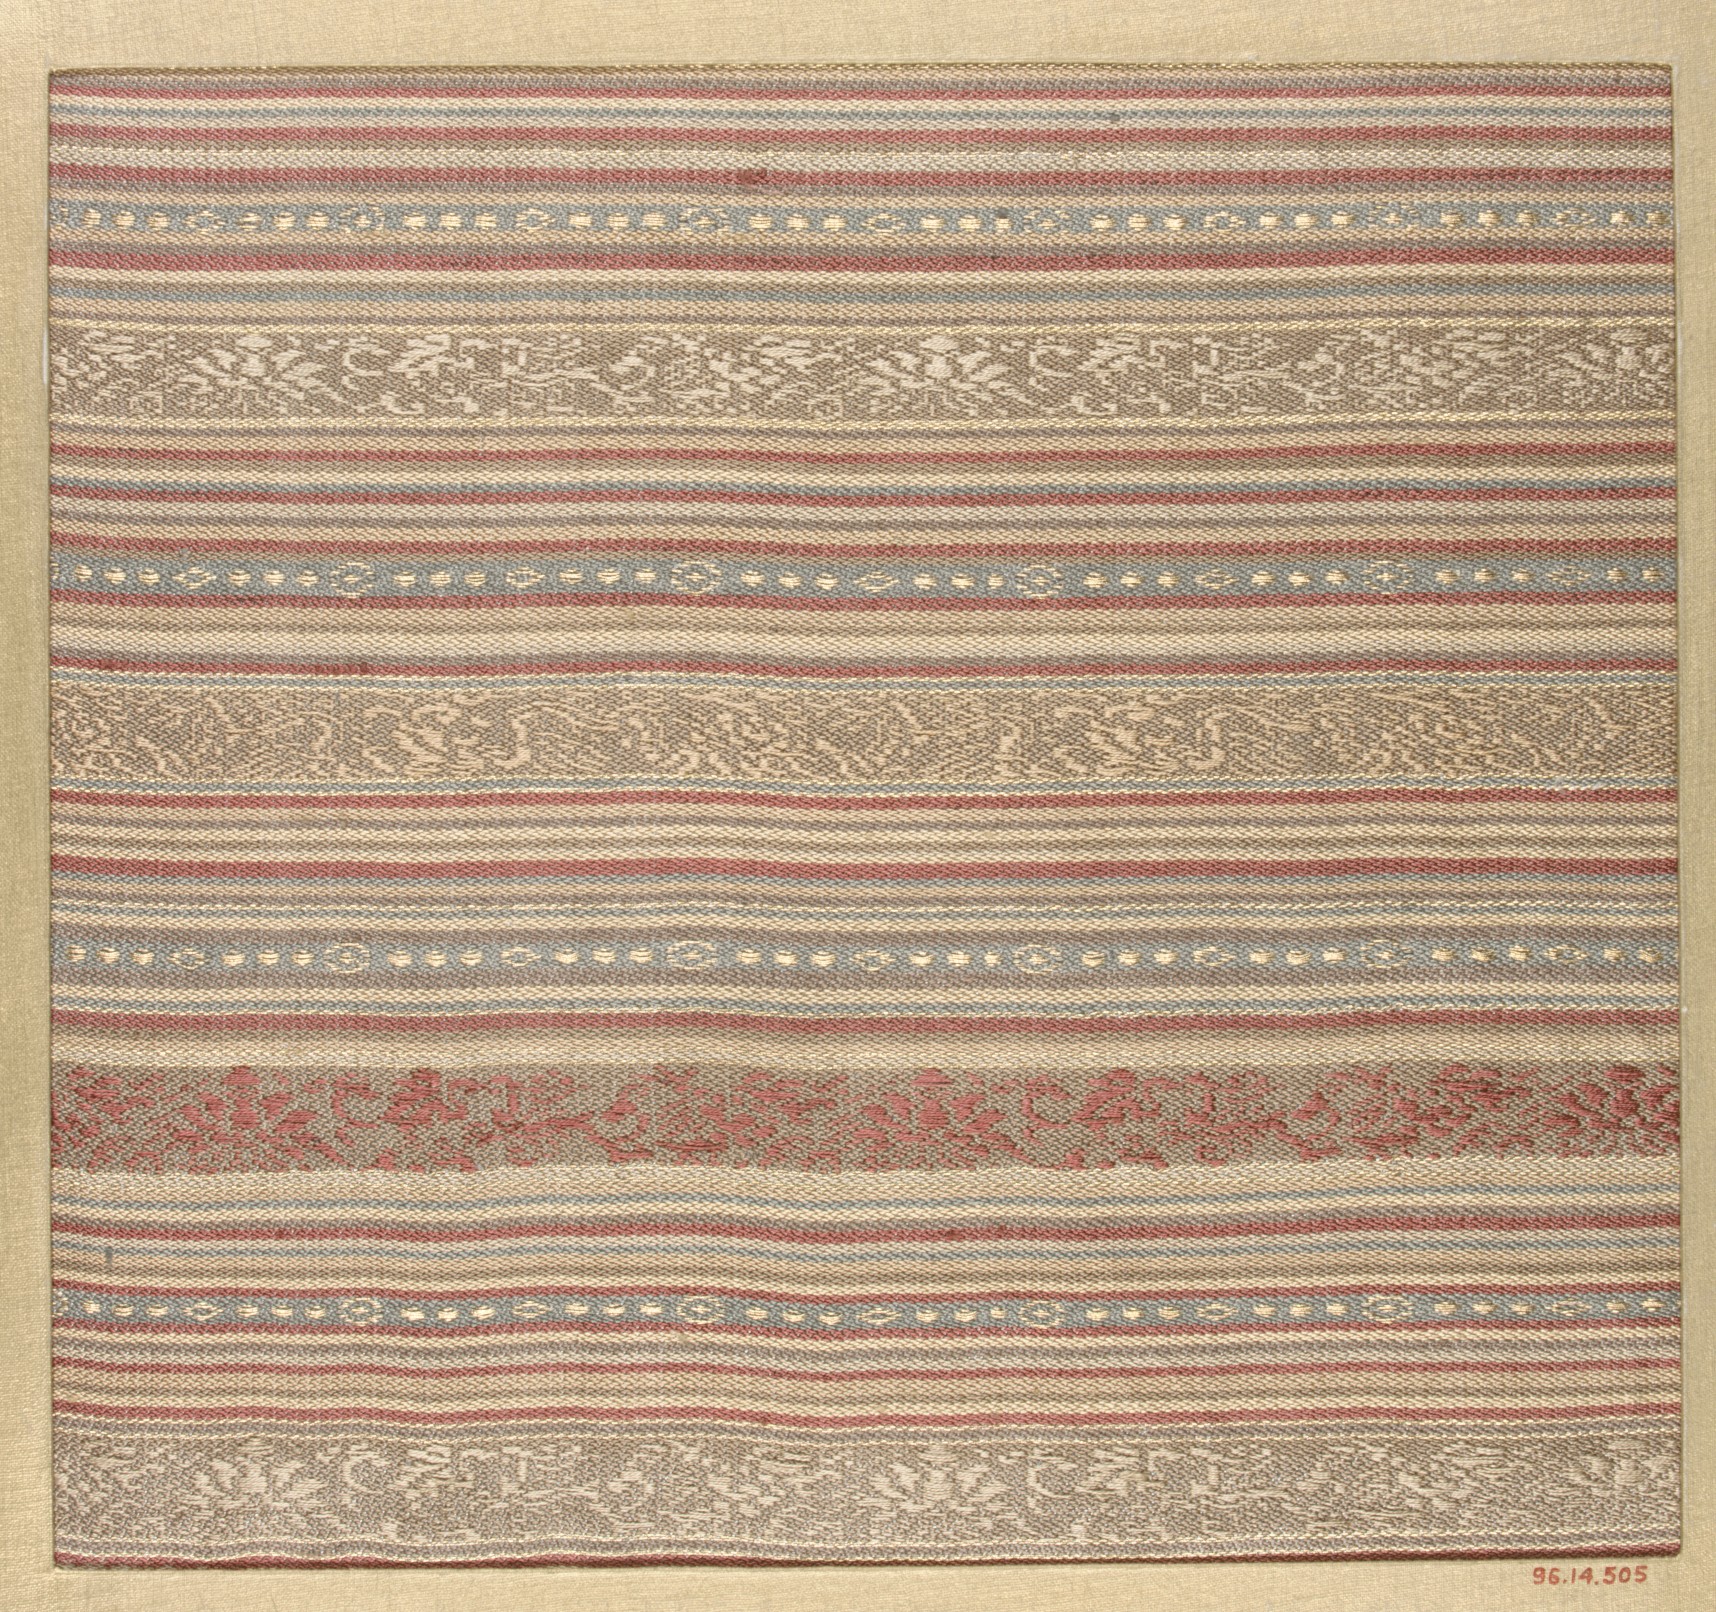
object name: piece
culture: japanese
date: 1701-1900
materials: silk